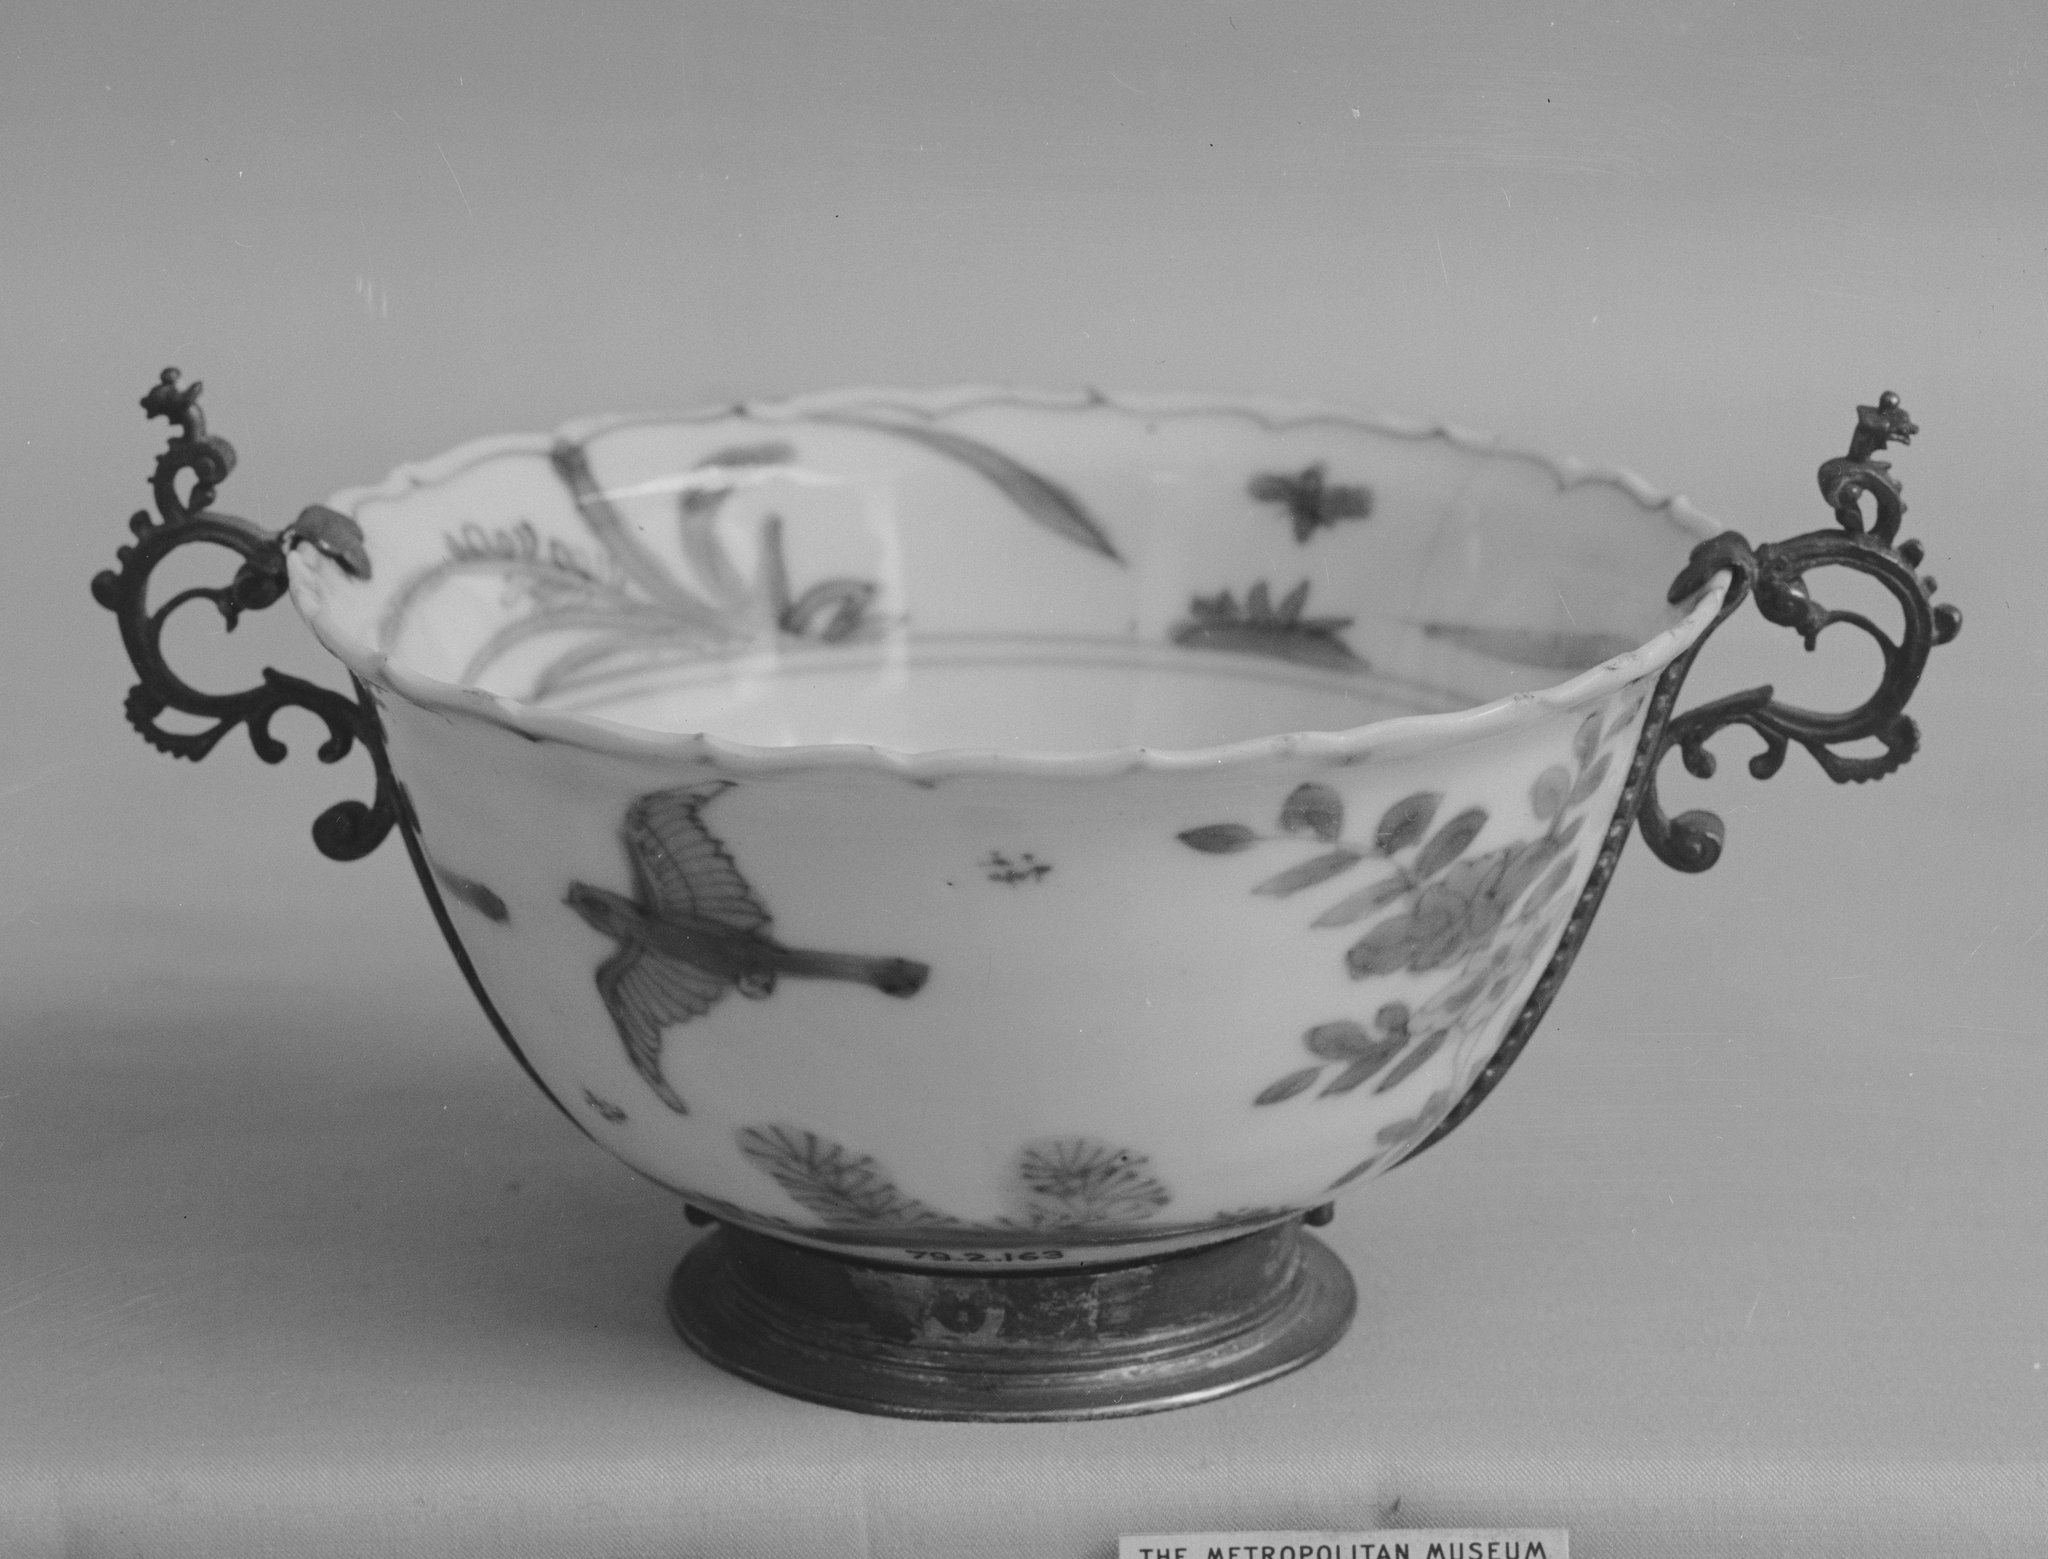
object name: cup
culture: chinese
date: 1567-1633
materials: porcelain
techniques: painting, underglaze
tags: birds,flowers